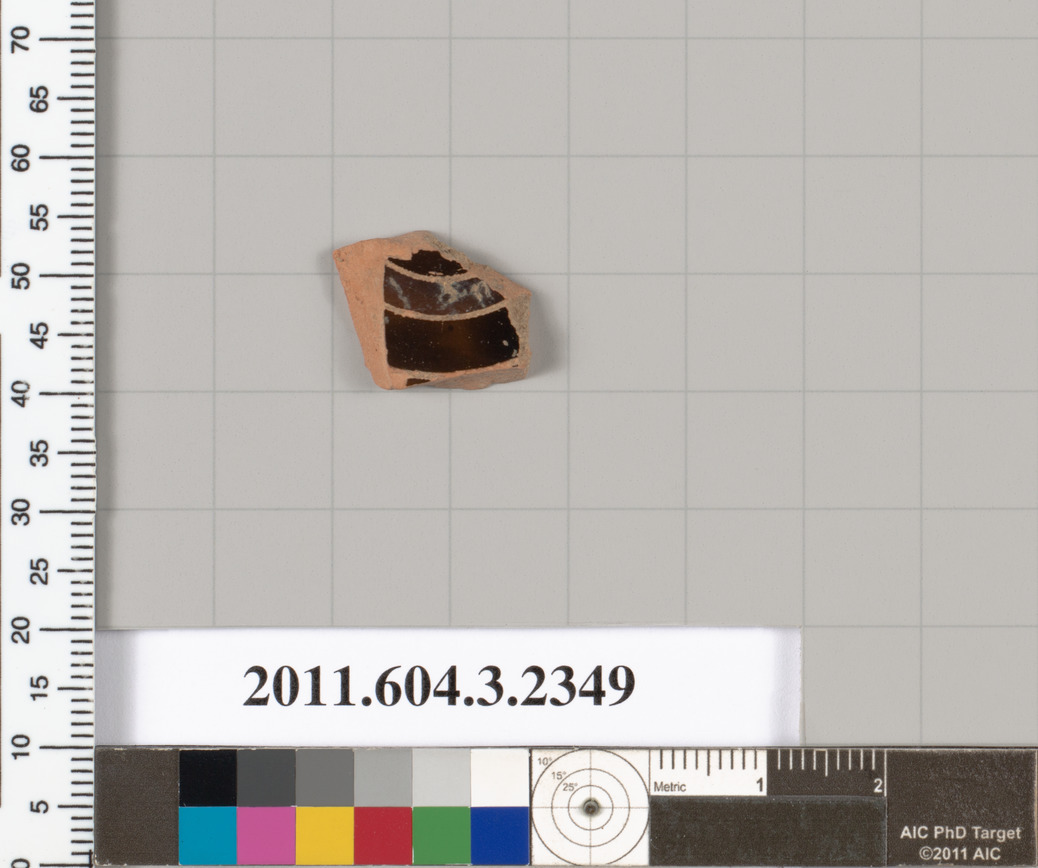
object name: kylix fragment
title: Terracotta fragment of a kylix: eye-cup (drinking cup)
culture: greek, attic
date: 540-520 BCE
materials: terracotta